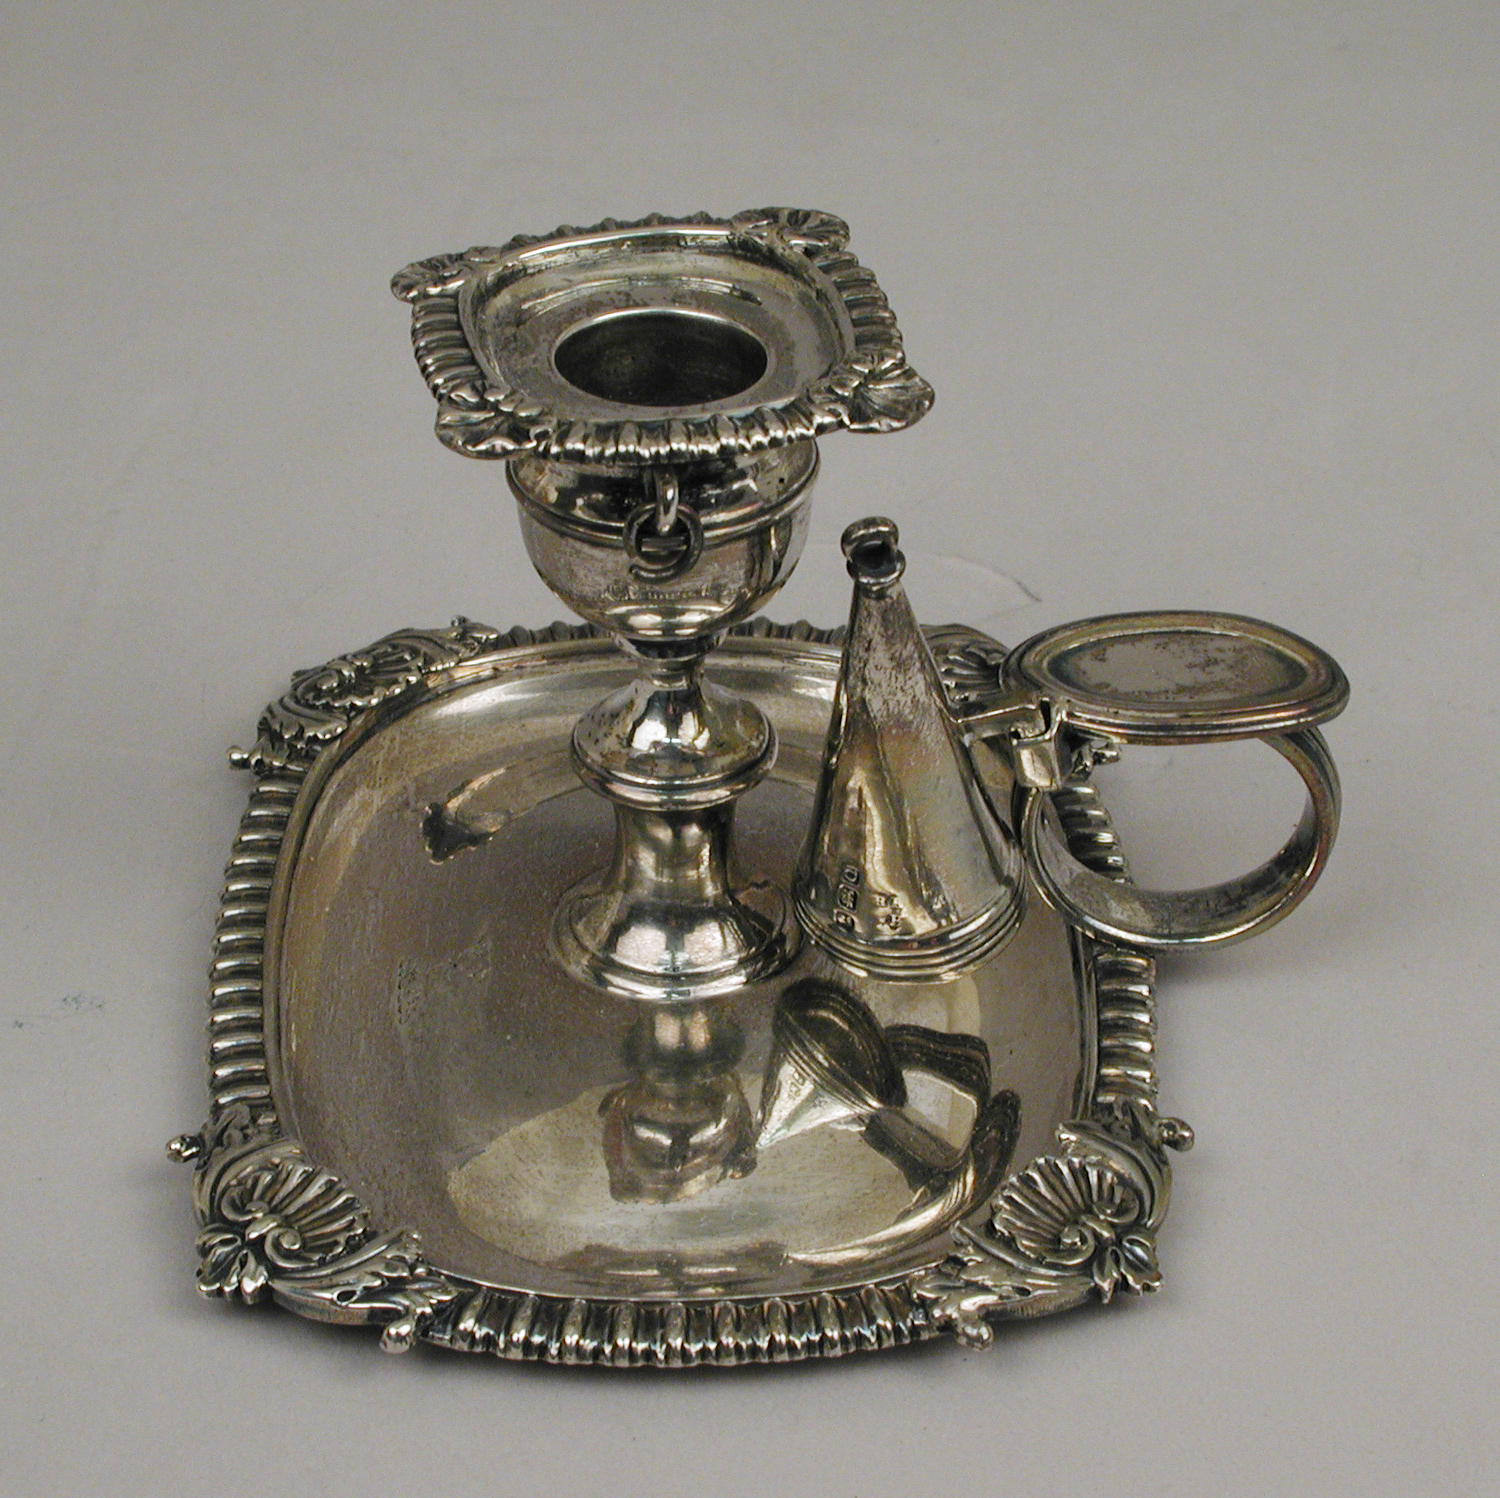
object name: chamber candlestick or taperstick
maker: rebecca emes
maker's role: maker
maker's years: 1808-1825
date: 1811-1812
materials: silver